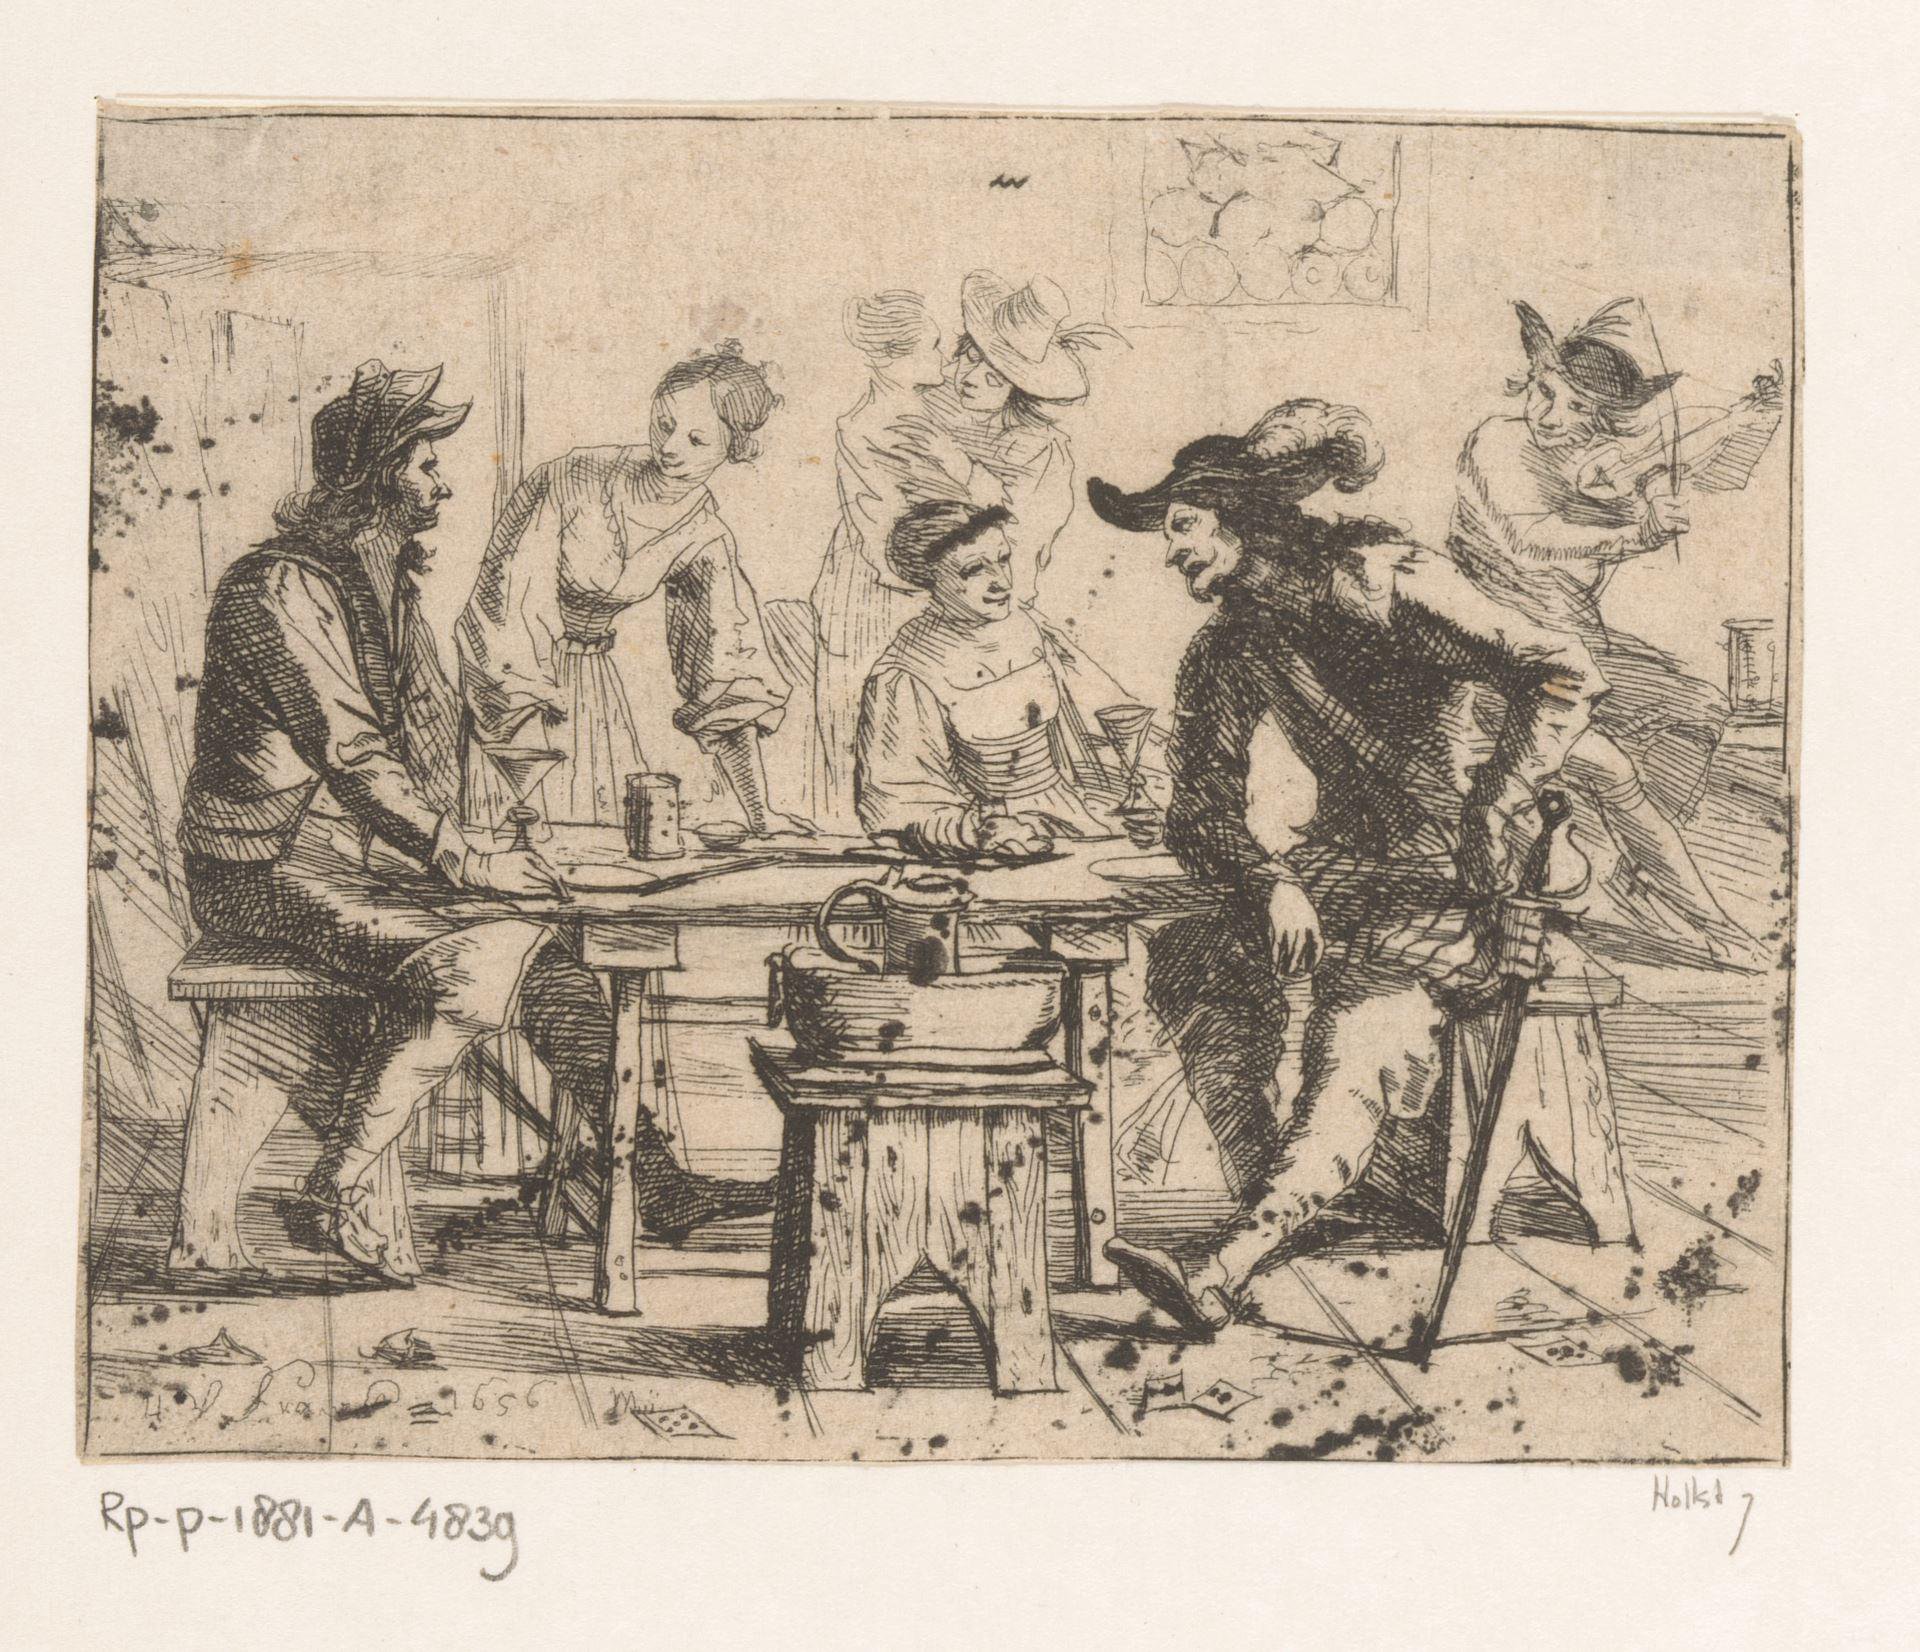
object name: print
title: Soldaten en vrouwen in een herberg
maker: hans ulrich franck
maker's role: draughtsman, print maker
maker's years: 1603-1680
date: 1605-1656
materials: paper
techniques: etching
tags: the soldier; the soldier's life, hotel, hostelry, inn, lovers; courting, flirting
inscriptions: collector's mark: Lugt 2228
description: Prent uit een serie van vijfentwintig militaire voorstellingen, waarvan tien in de collectie van het RMA aanwezig zijn.